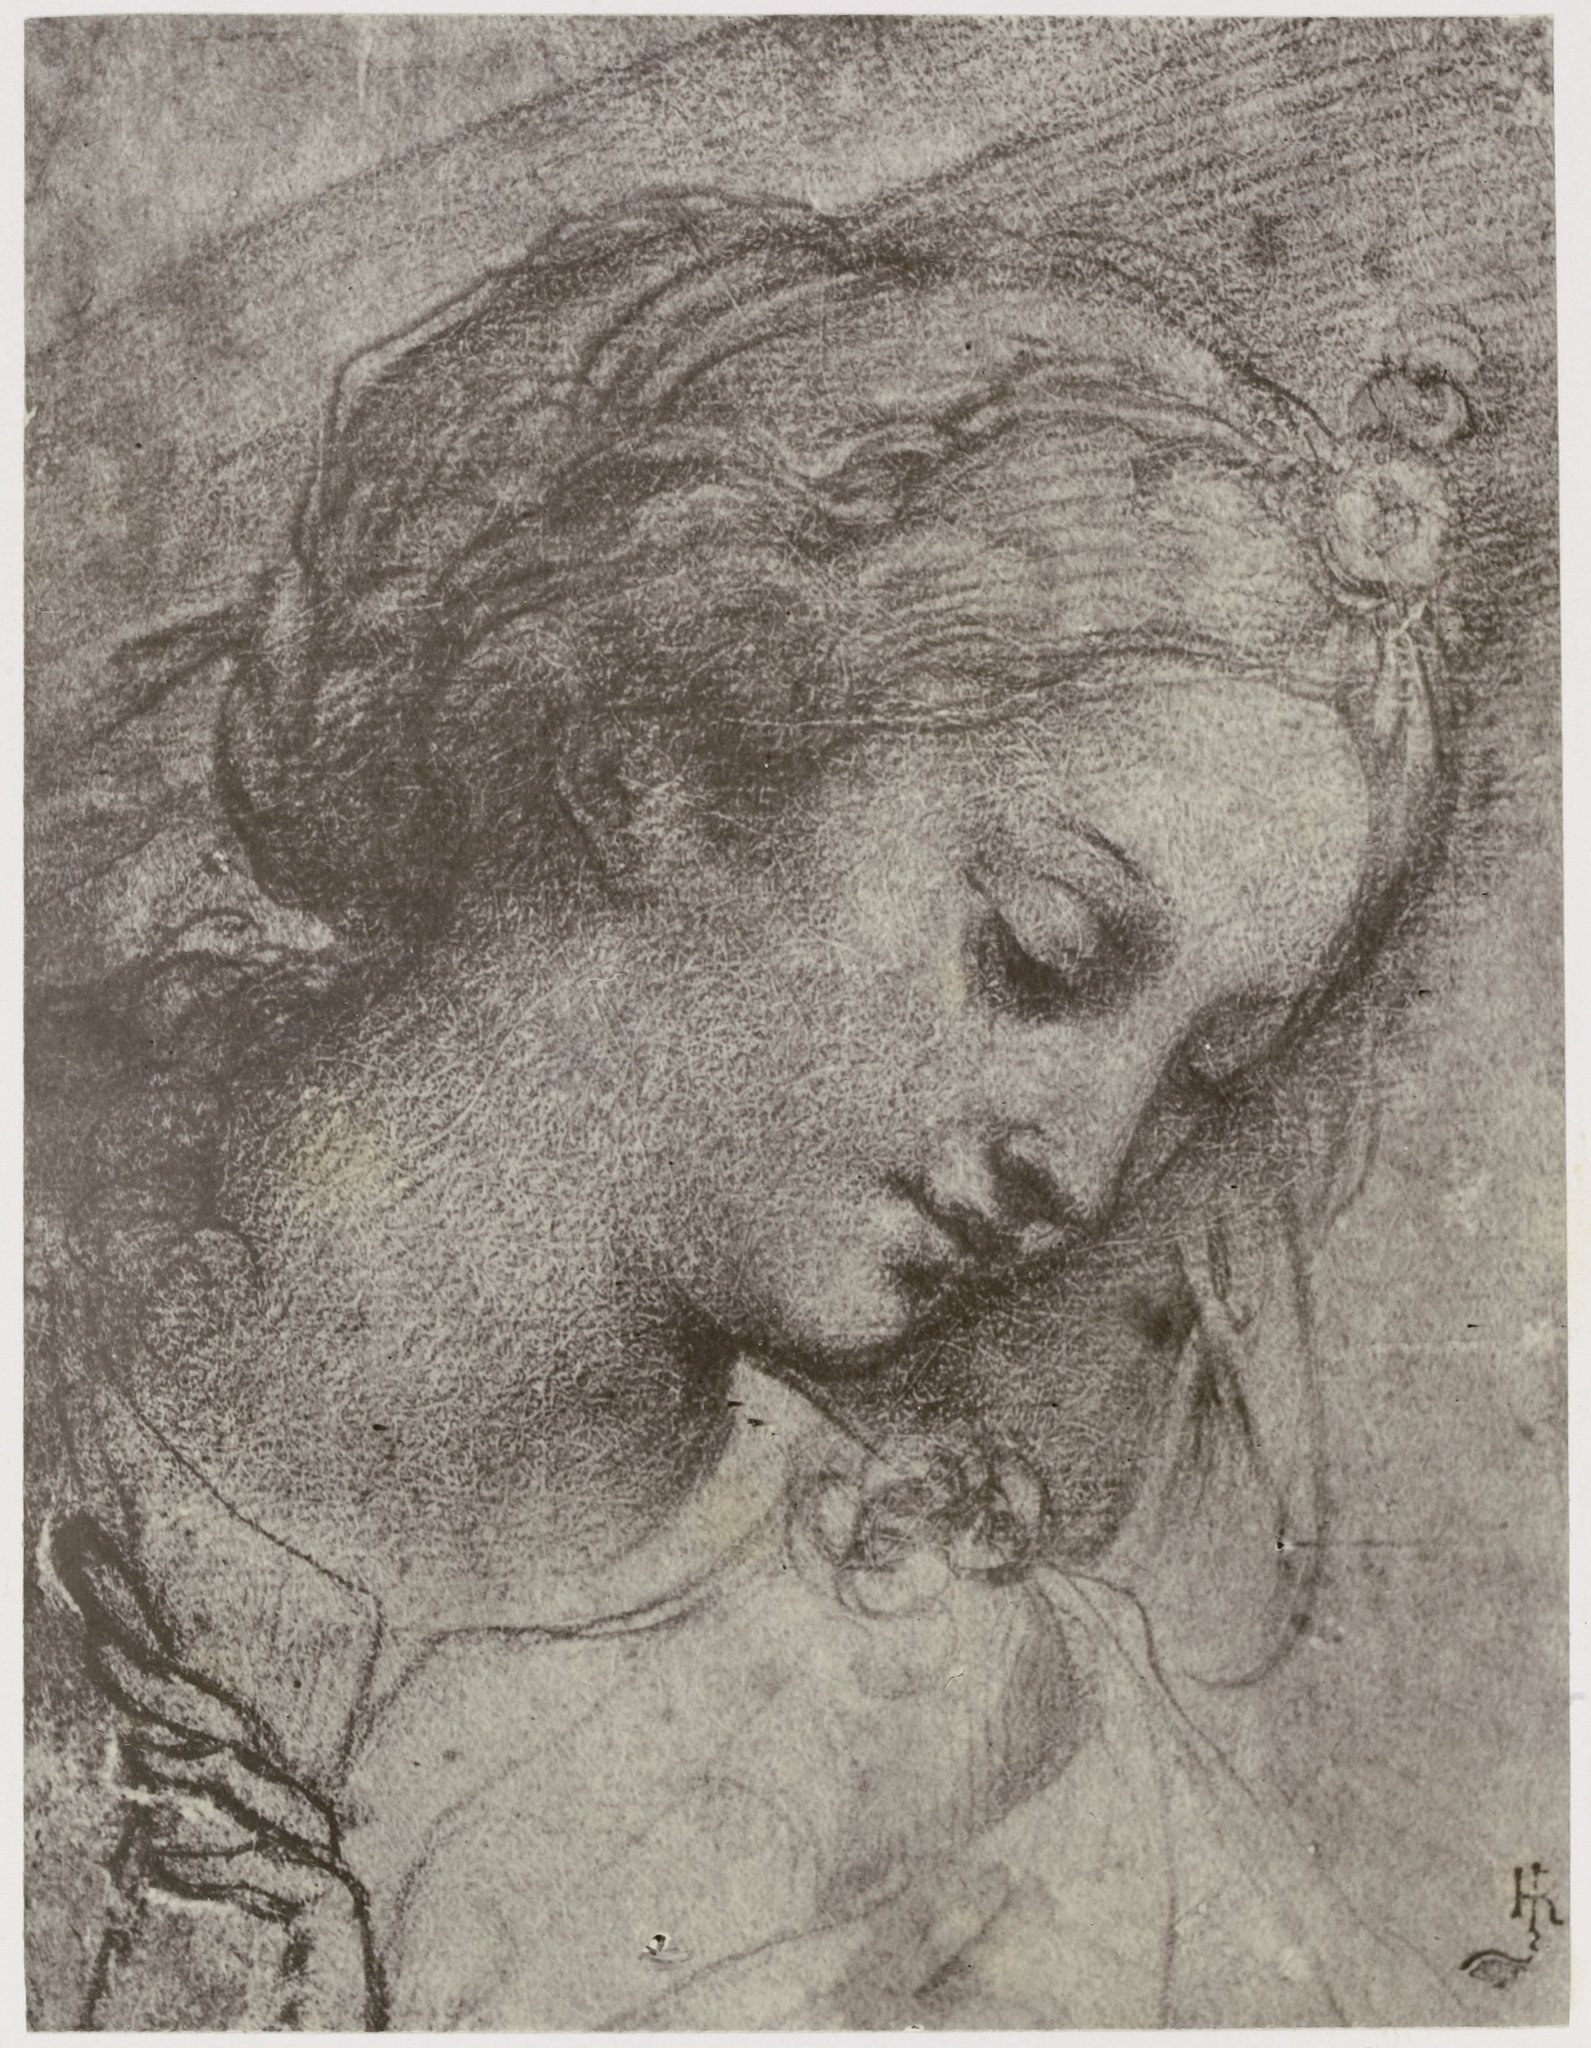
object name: photograph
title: Carlo Dolci, Head of the Virgin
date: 1855-1858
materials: cardboard, paper, photographic support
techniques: albumen print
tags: drawing, sketch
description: Fotoreproductie van tekening in 'The Reveley Collection of Drawings at Brynygwin', afb. 9.